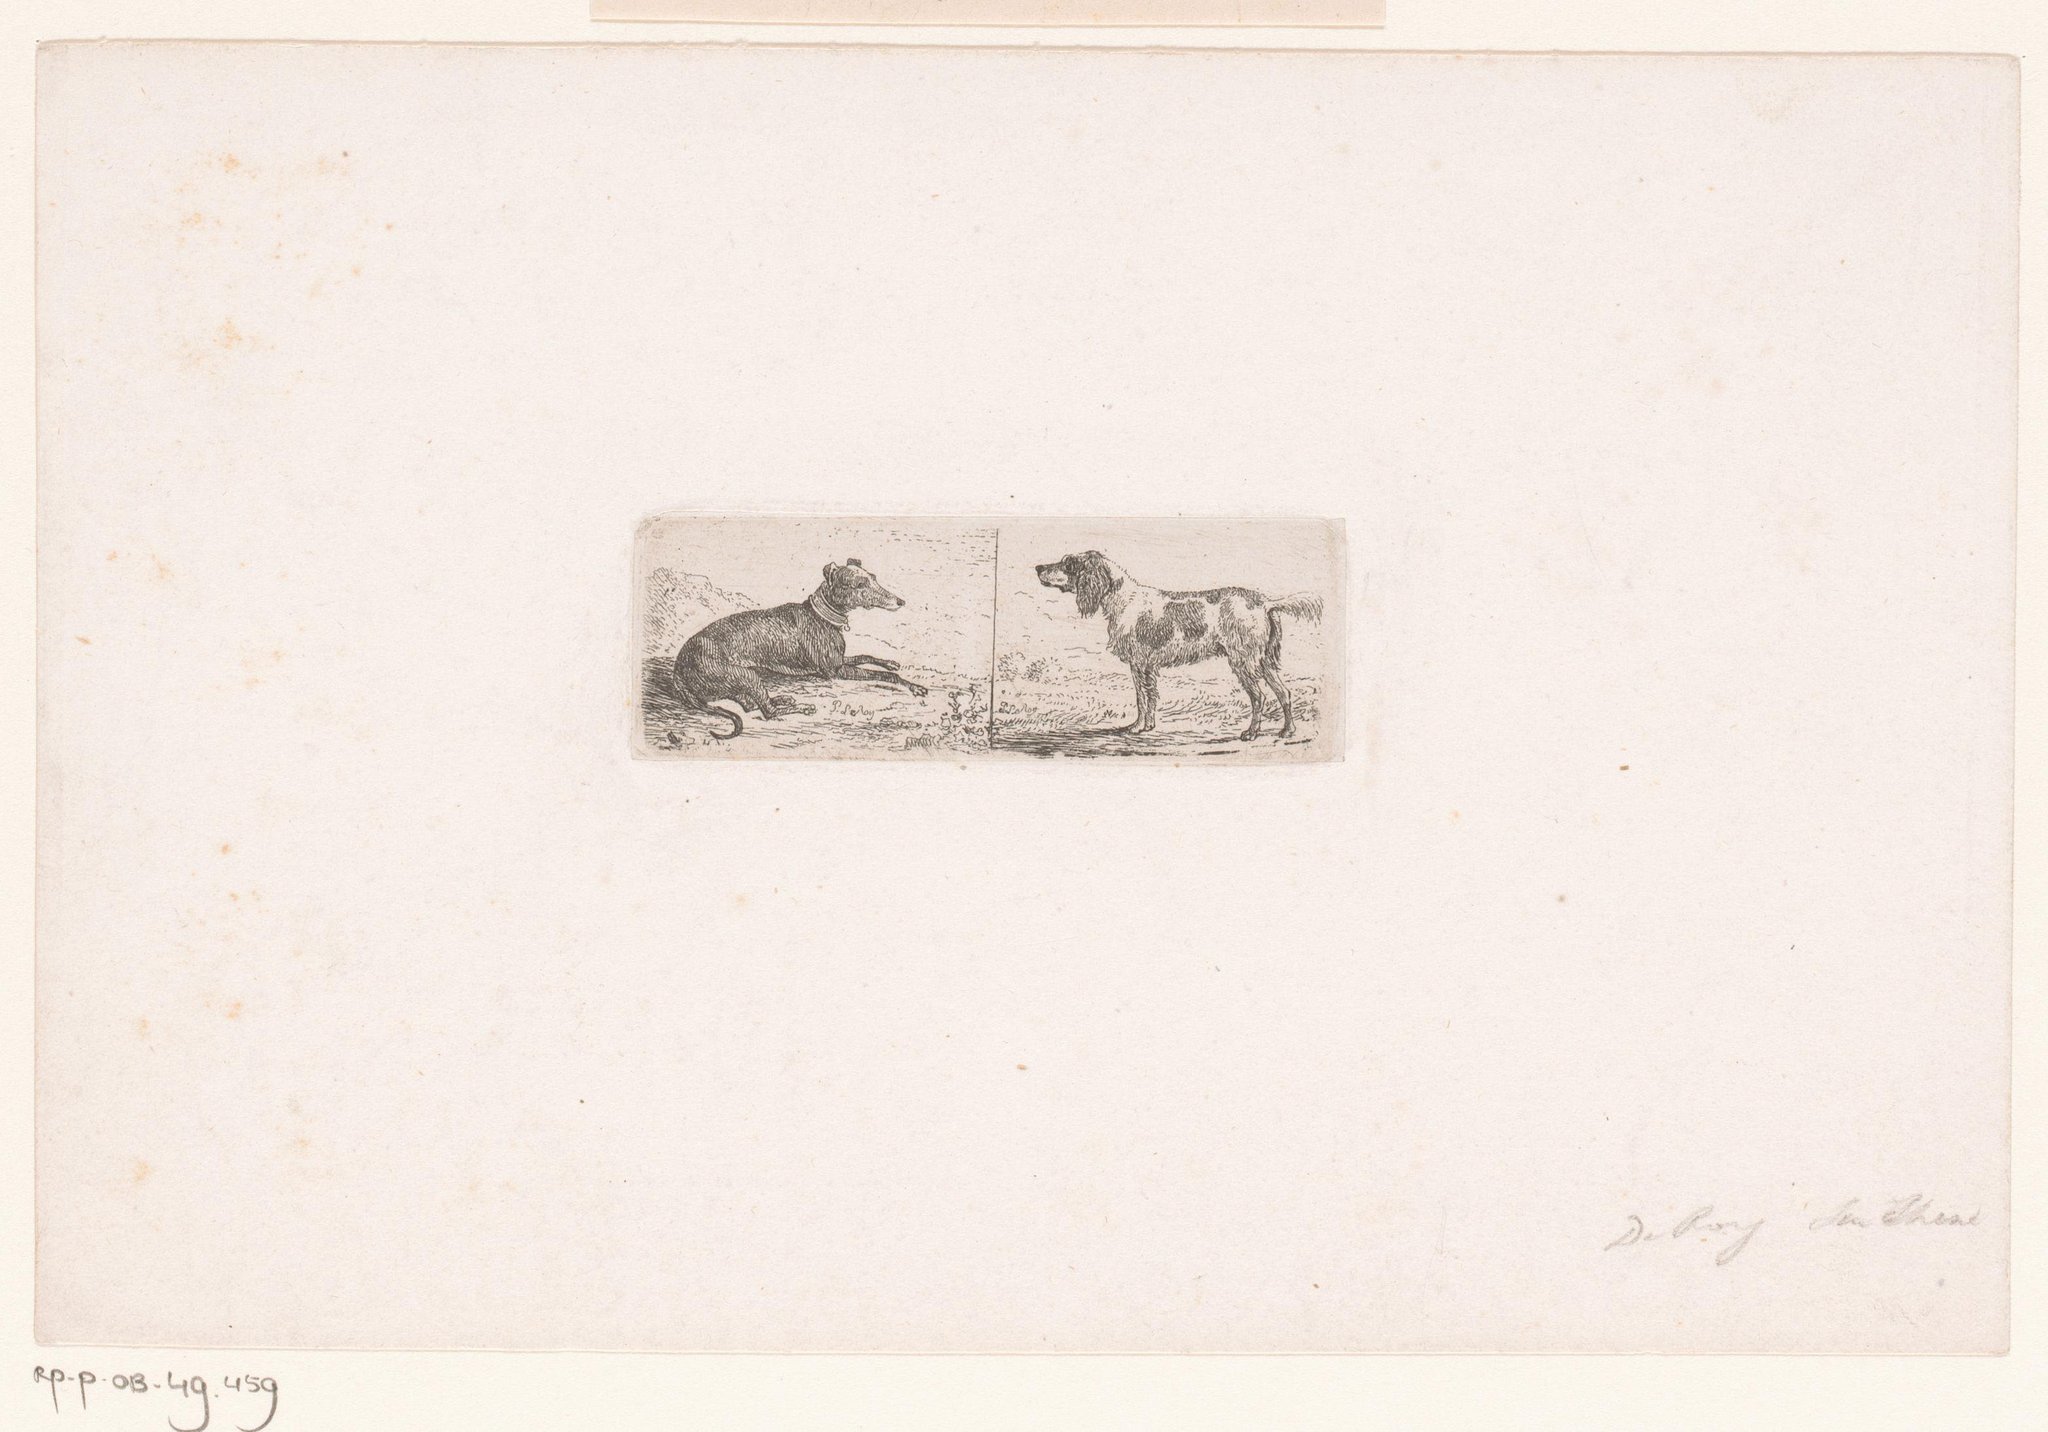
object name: print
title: Twee honden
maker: jean baptiste de roy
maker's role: print maker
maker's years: 1759-1839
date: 1769-1839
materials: paper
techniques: etching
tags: dog